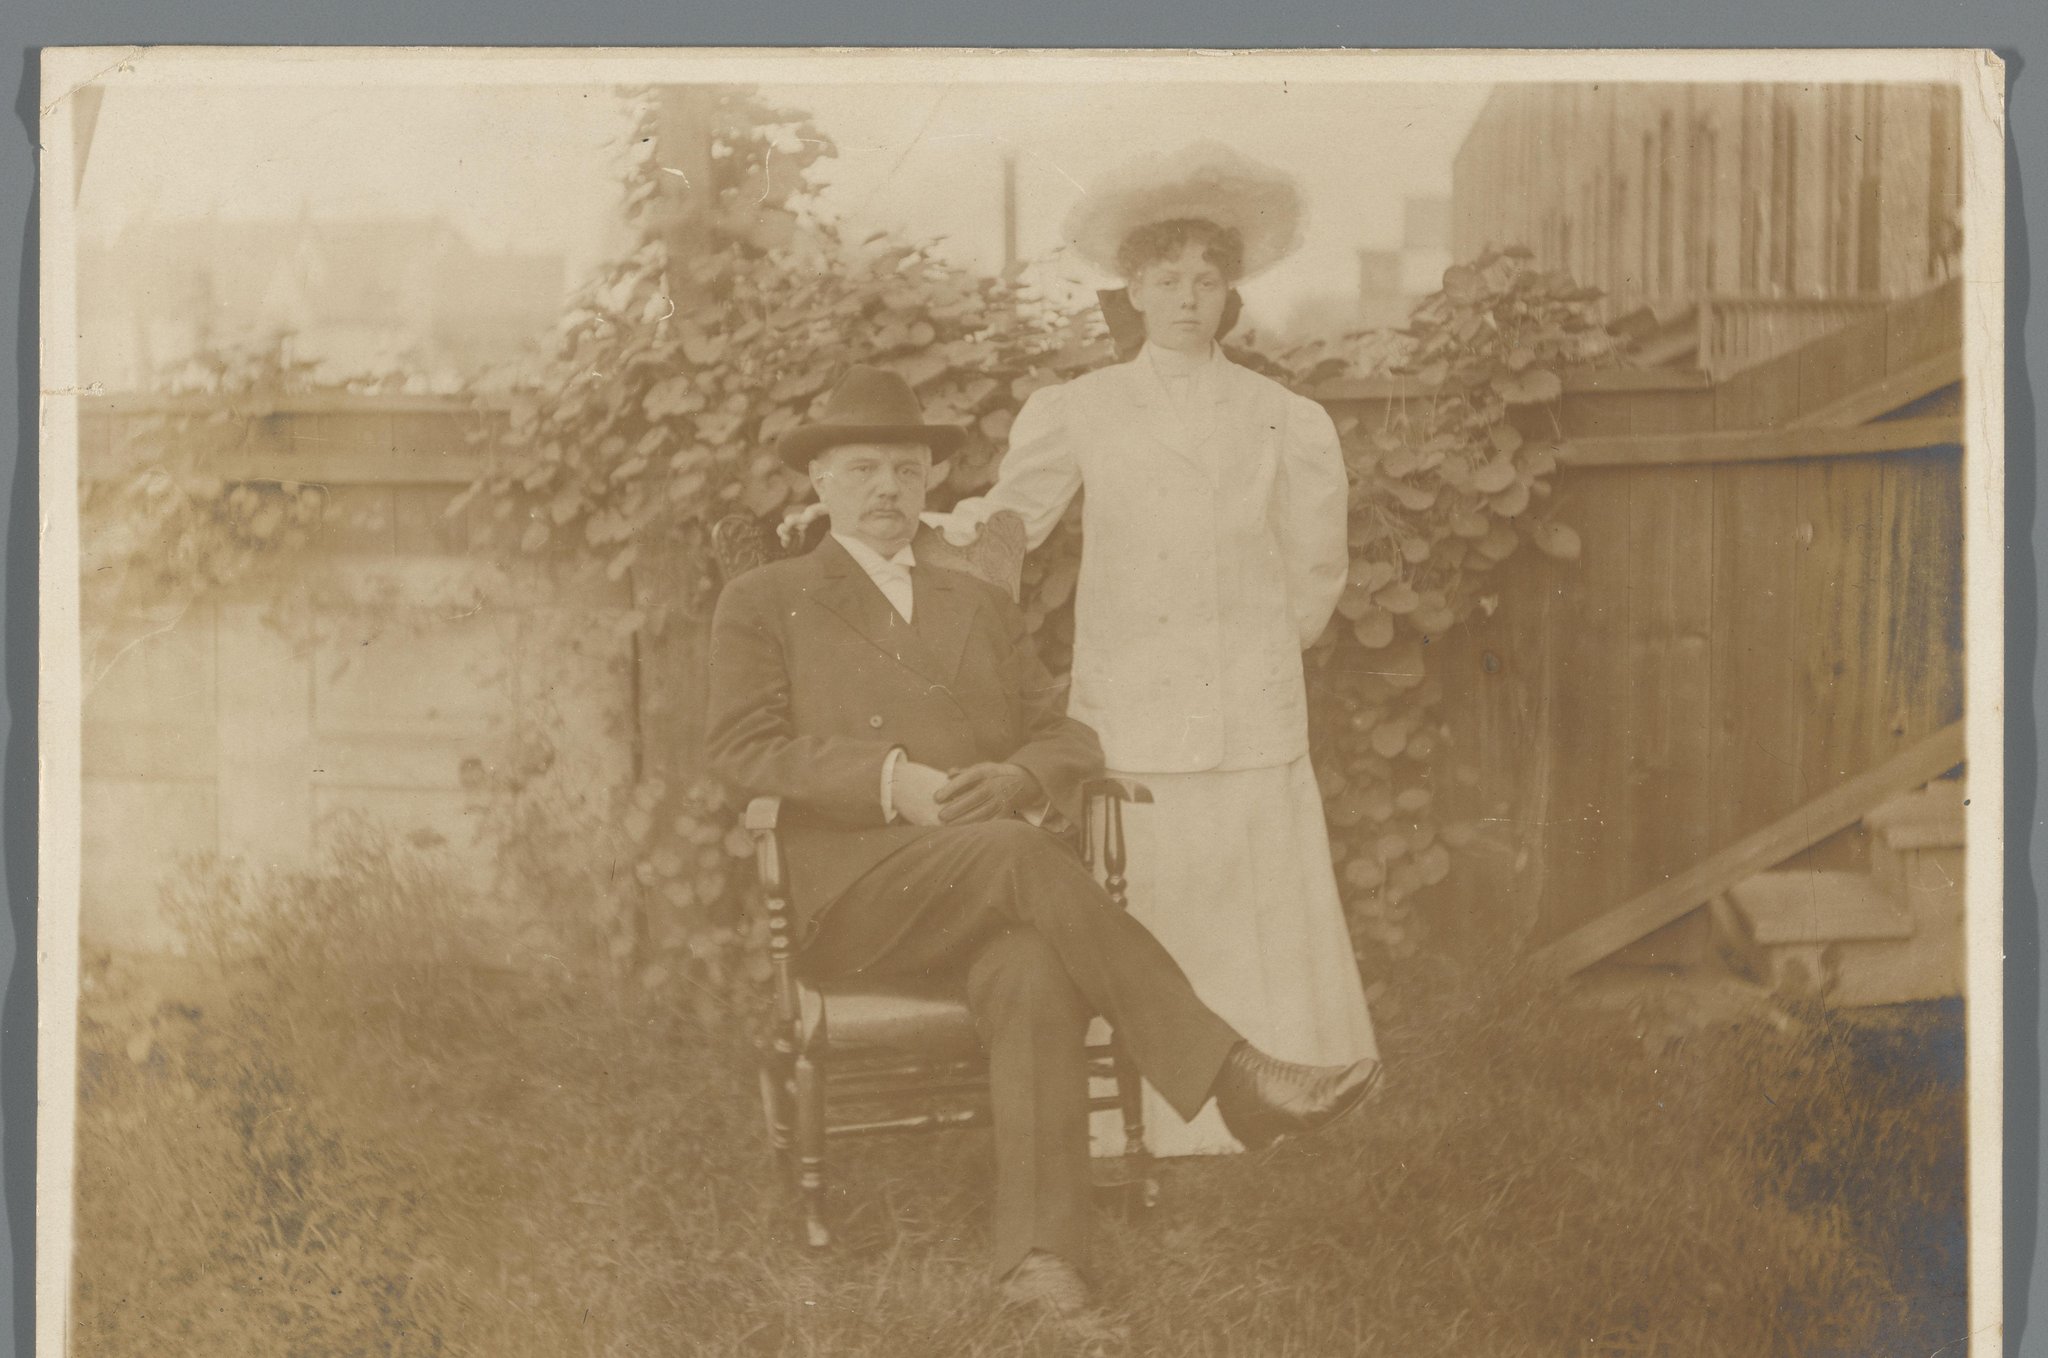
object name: photograph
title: Portret van een onbekende man en vrouw in een tuin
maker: Anonymous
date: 1890-1910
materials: paper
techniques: gelatin silver print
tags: adult woman, adult man, anonymous historical persons portrayed in a double portrait